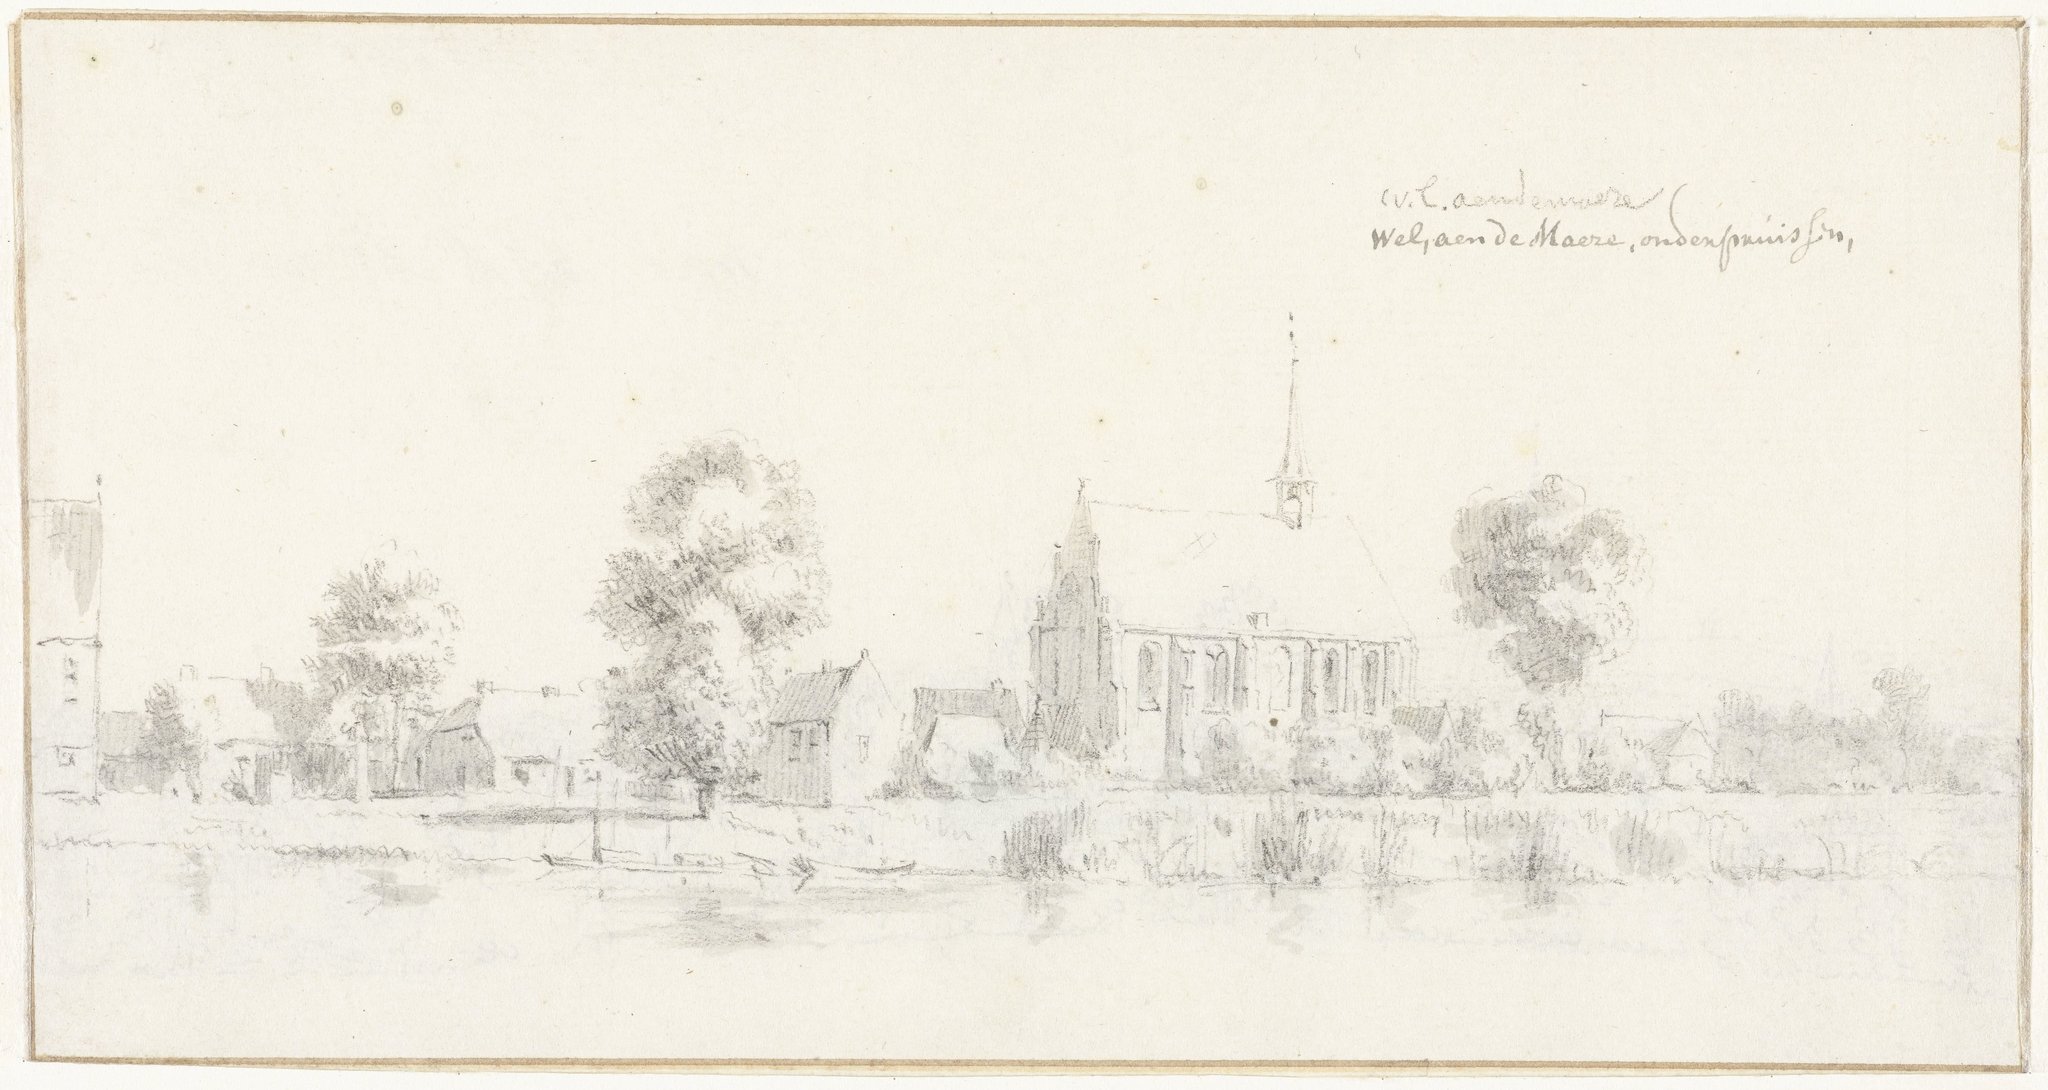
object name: drawing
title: Gezicht op Well, aan de Maas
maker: cornelis pronk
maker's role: draughtsman, painter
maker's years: 1691-1759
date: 1701-1759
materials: paper, pencil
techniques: brush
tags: river, village, building of church